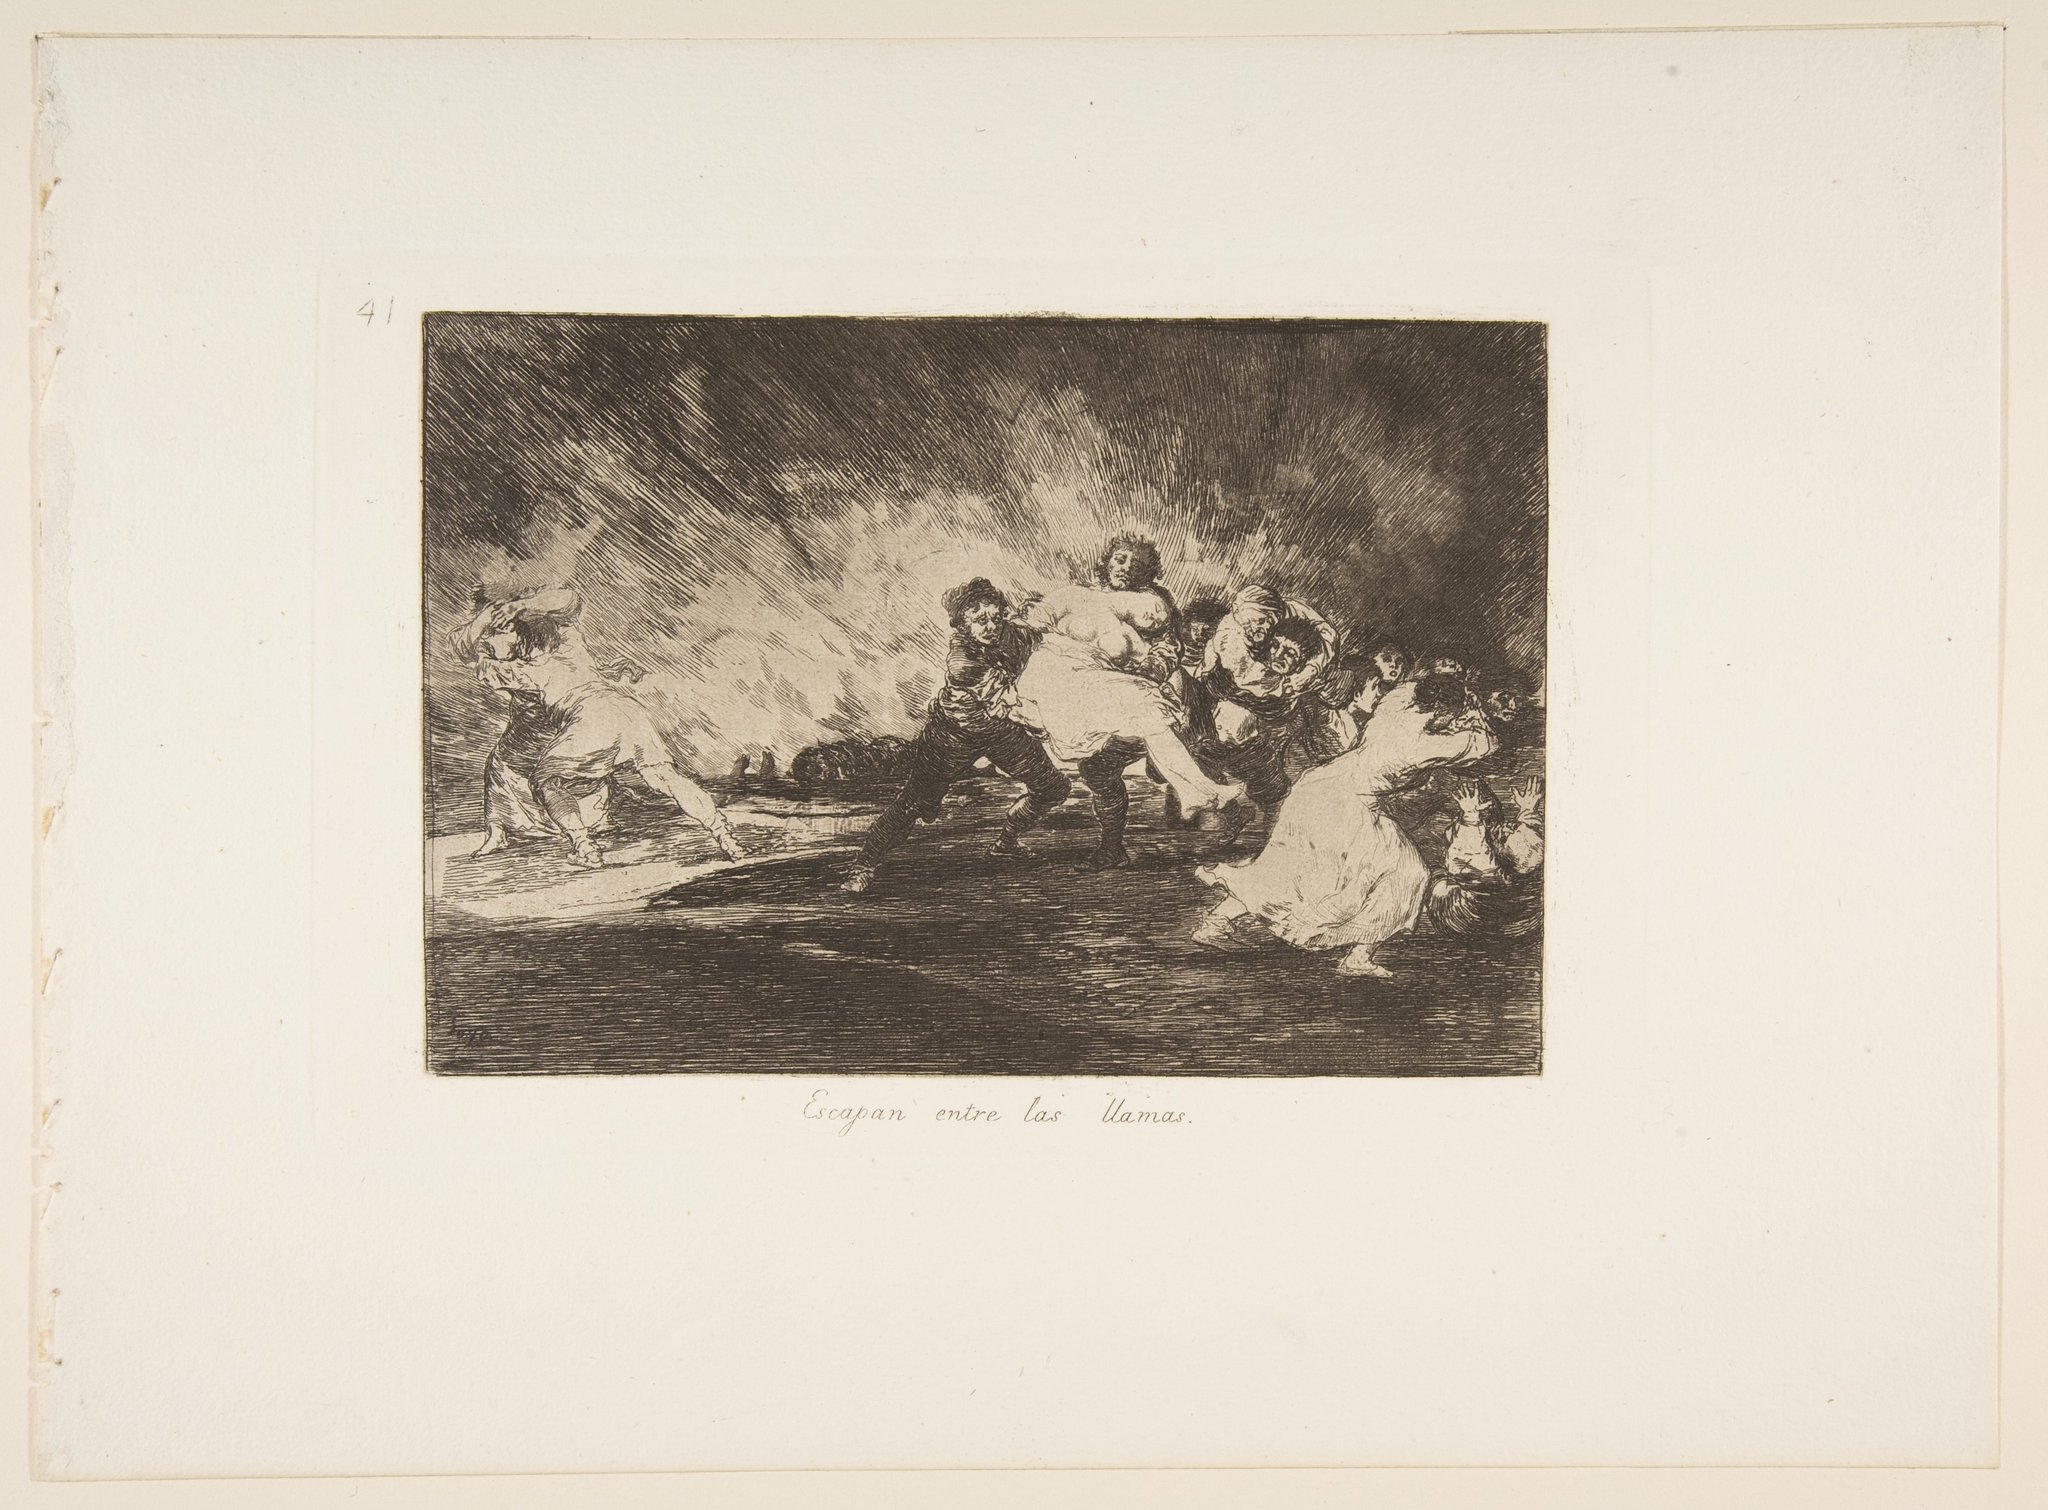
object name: print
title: Plate 41 from "The Disasters of War" (Los Desastres de La Guerra): 'They escape through the flames' (Escapan entre las llamas)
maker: goya (francisco de goya y lucientes)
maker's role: artist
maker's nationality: spanish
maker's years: 1746-1828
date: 1810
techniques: engraving, etching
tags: human figures,fires